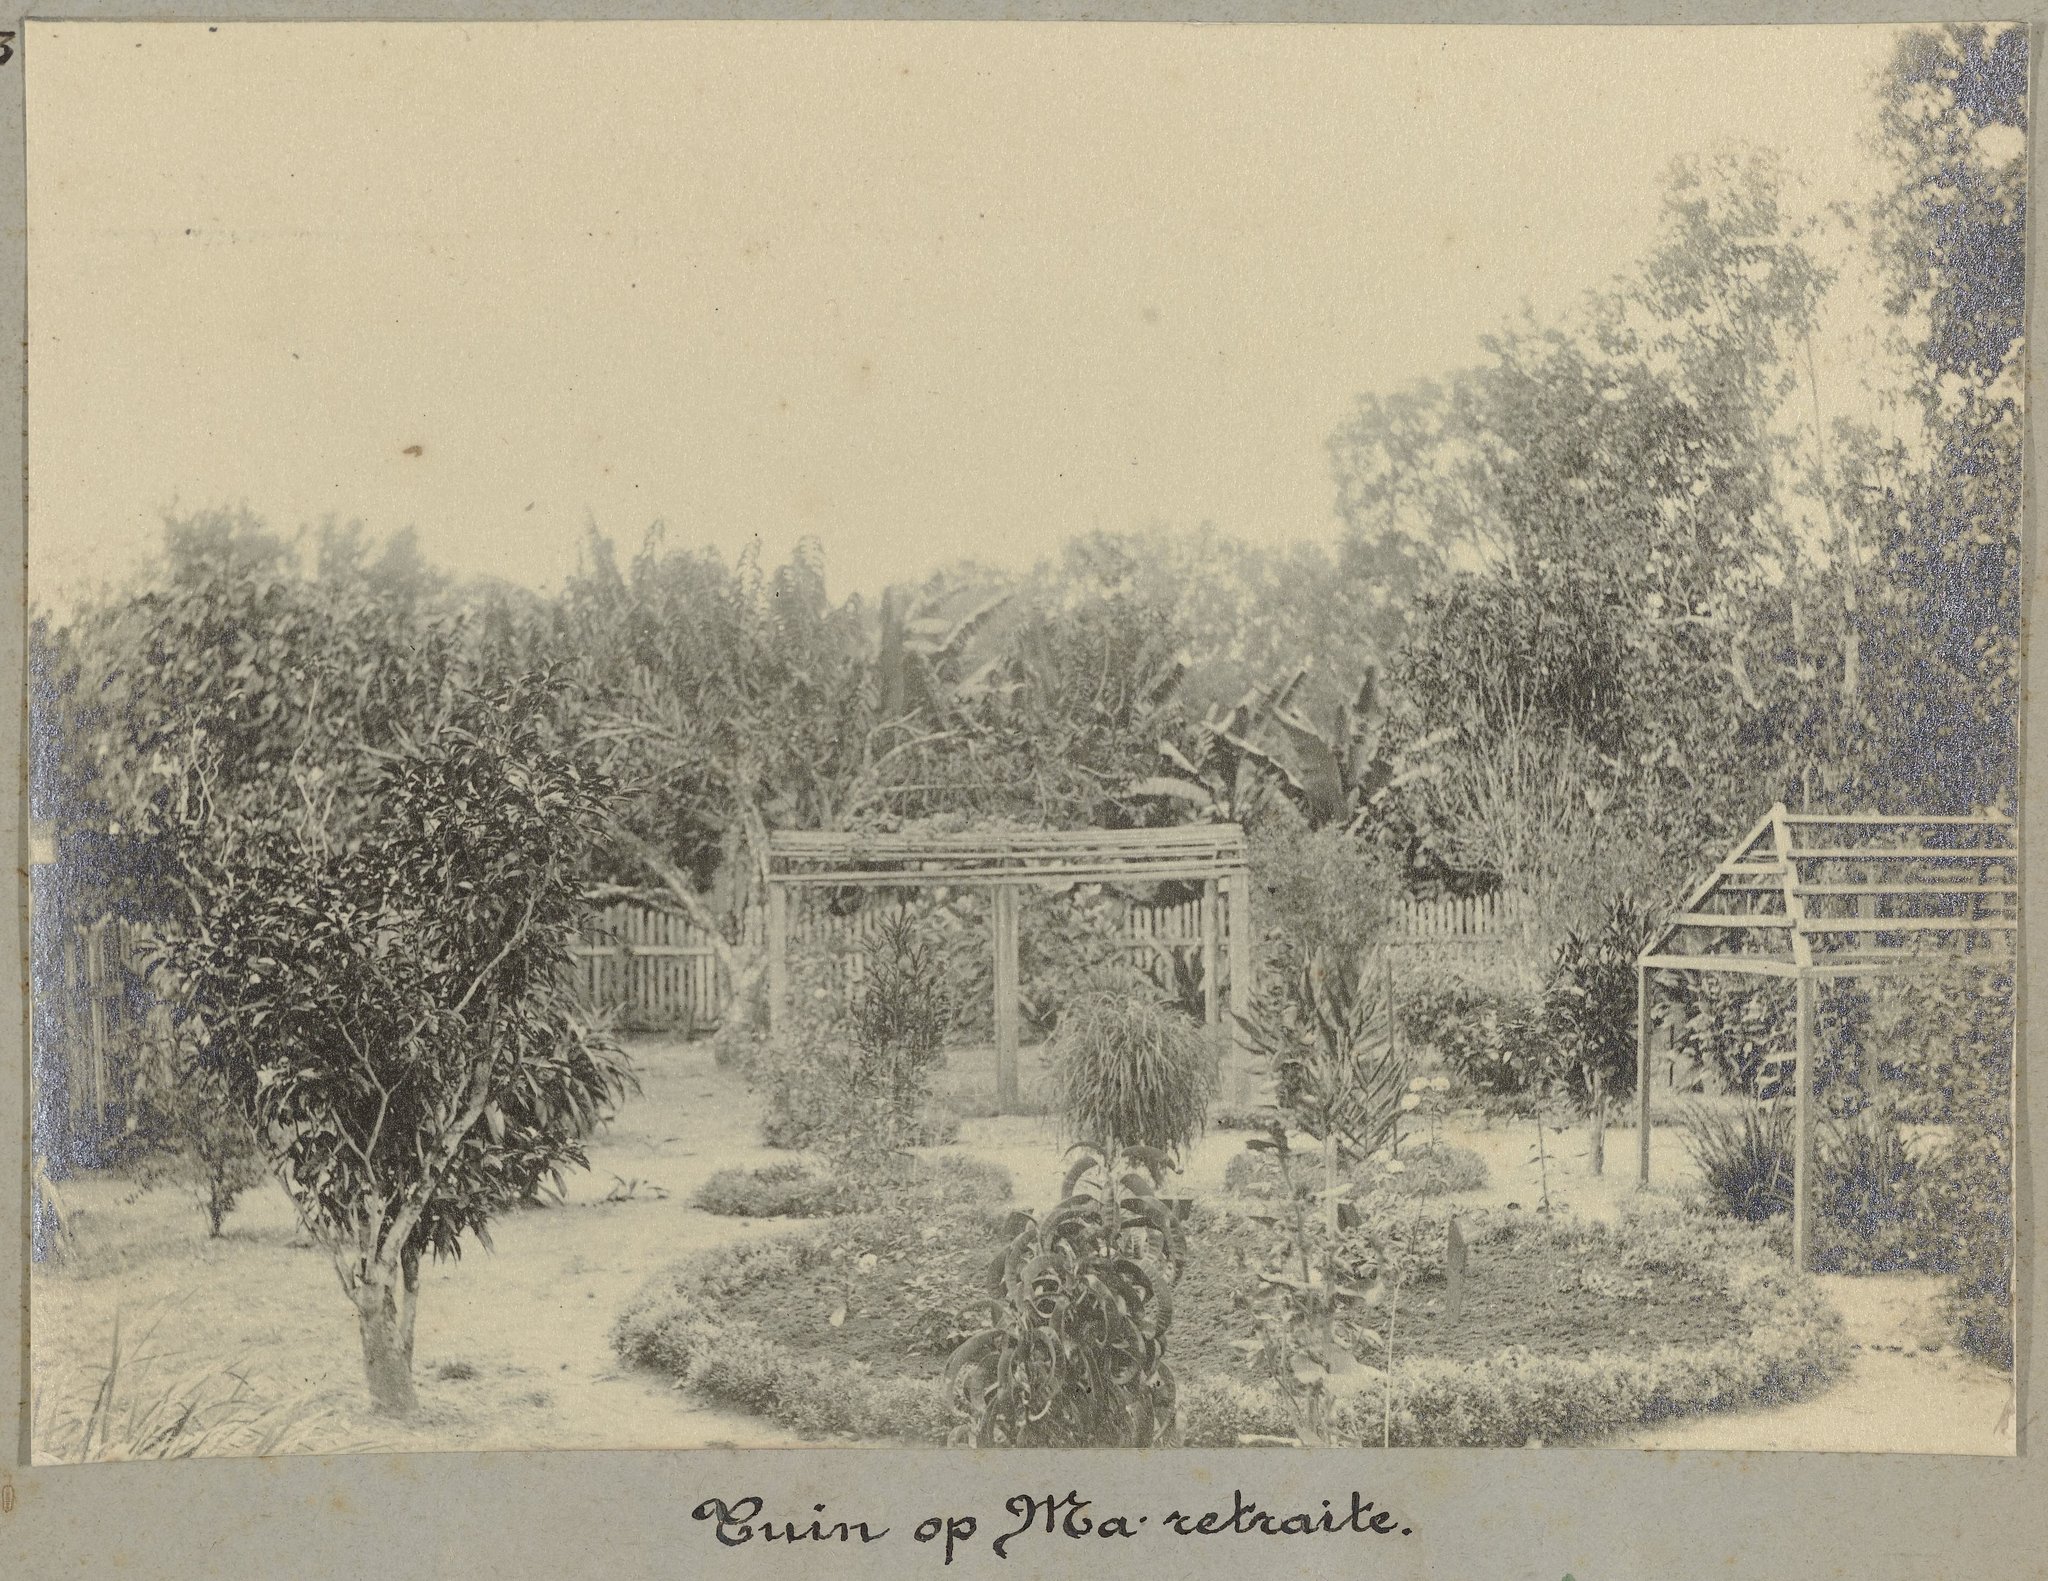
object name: photograph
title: Tuin op Ma retraite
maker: hendrik doijer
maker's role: engineer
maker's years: 1863-1925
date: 1903-1910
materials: photographic support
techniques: gelatin silver print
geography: suriname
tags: suriname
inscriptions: inscription: ‘D3 / Tuin op Ma retraite.’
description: Gezicht in de tuin met aangeplante bomen en struiken op de plantage Ma retraite. Onderdeel van het fotoalbum Souvenir de Voyage (deel 2), over het leven van de familie Doijer in en rond de plantage Ma Retraite in Suriname in de jaren 1903-1910.